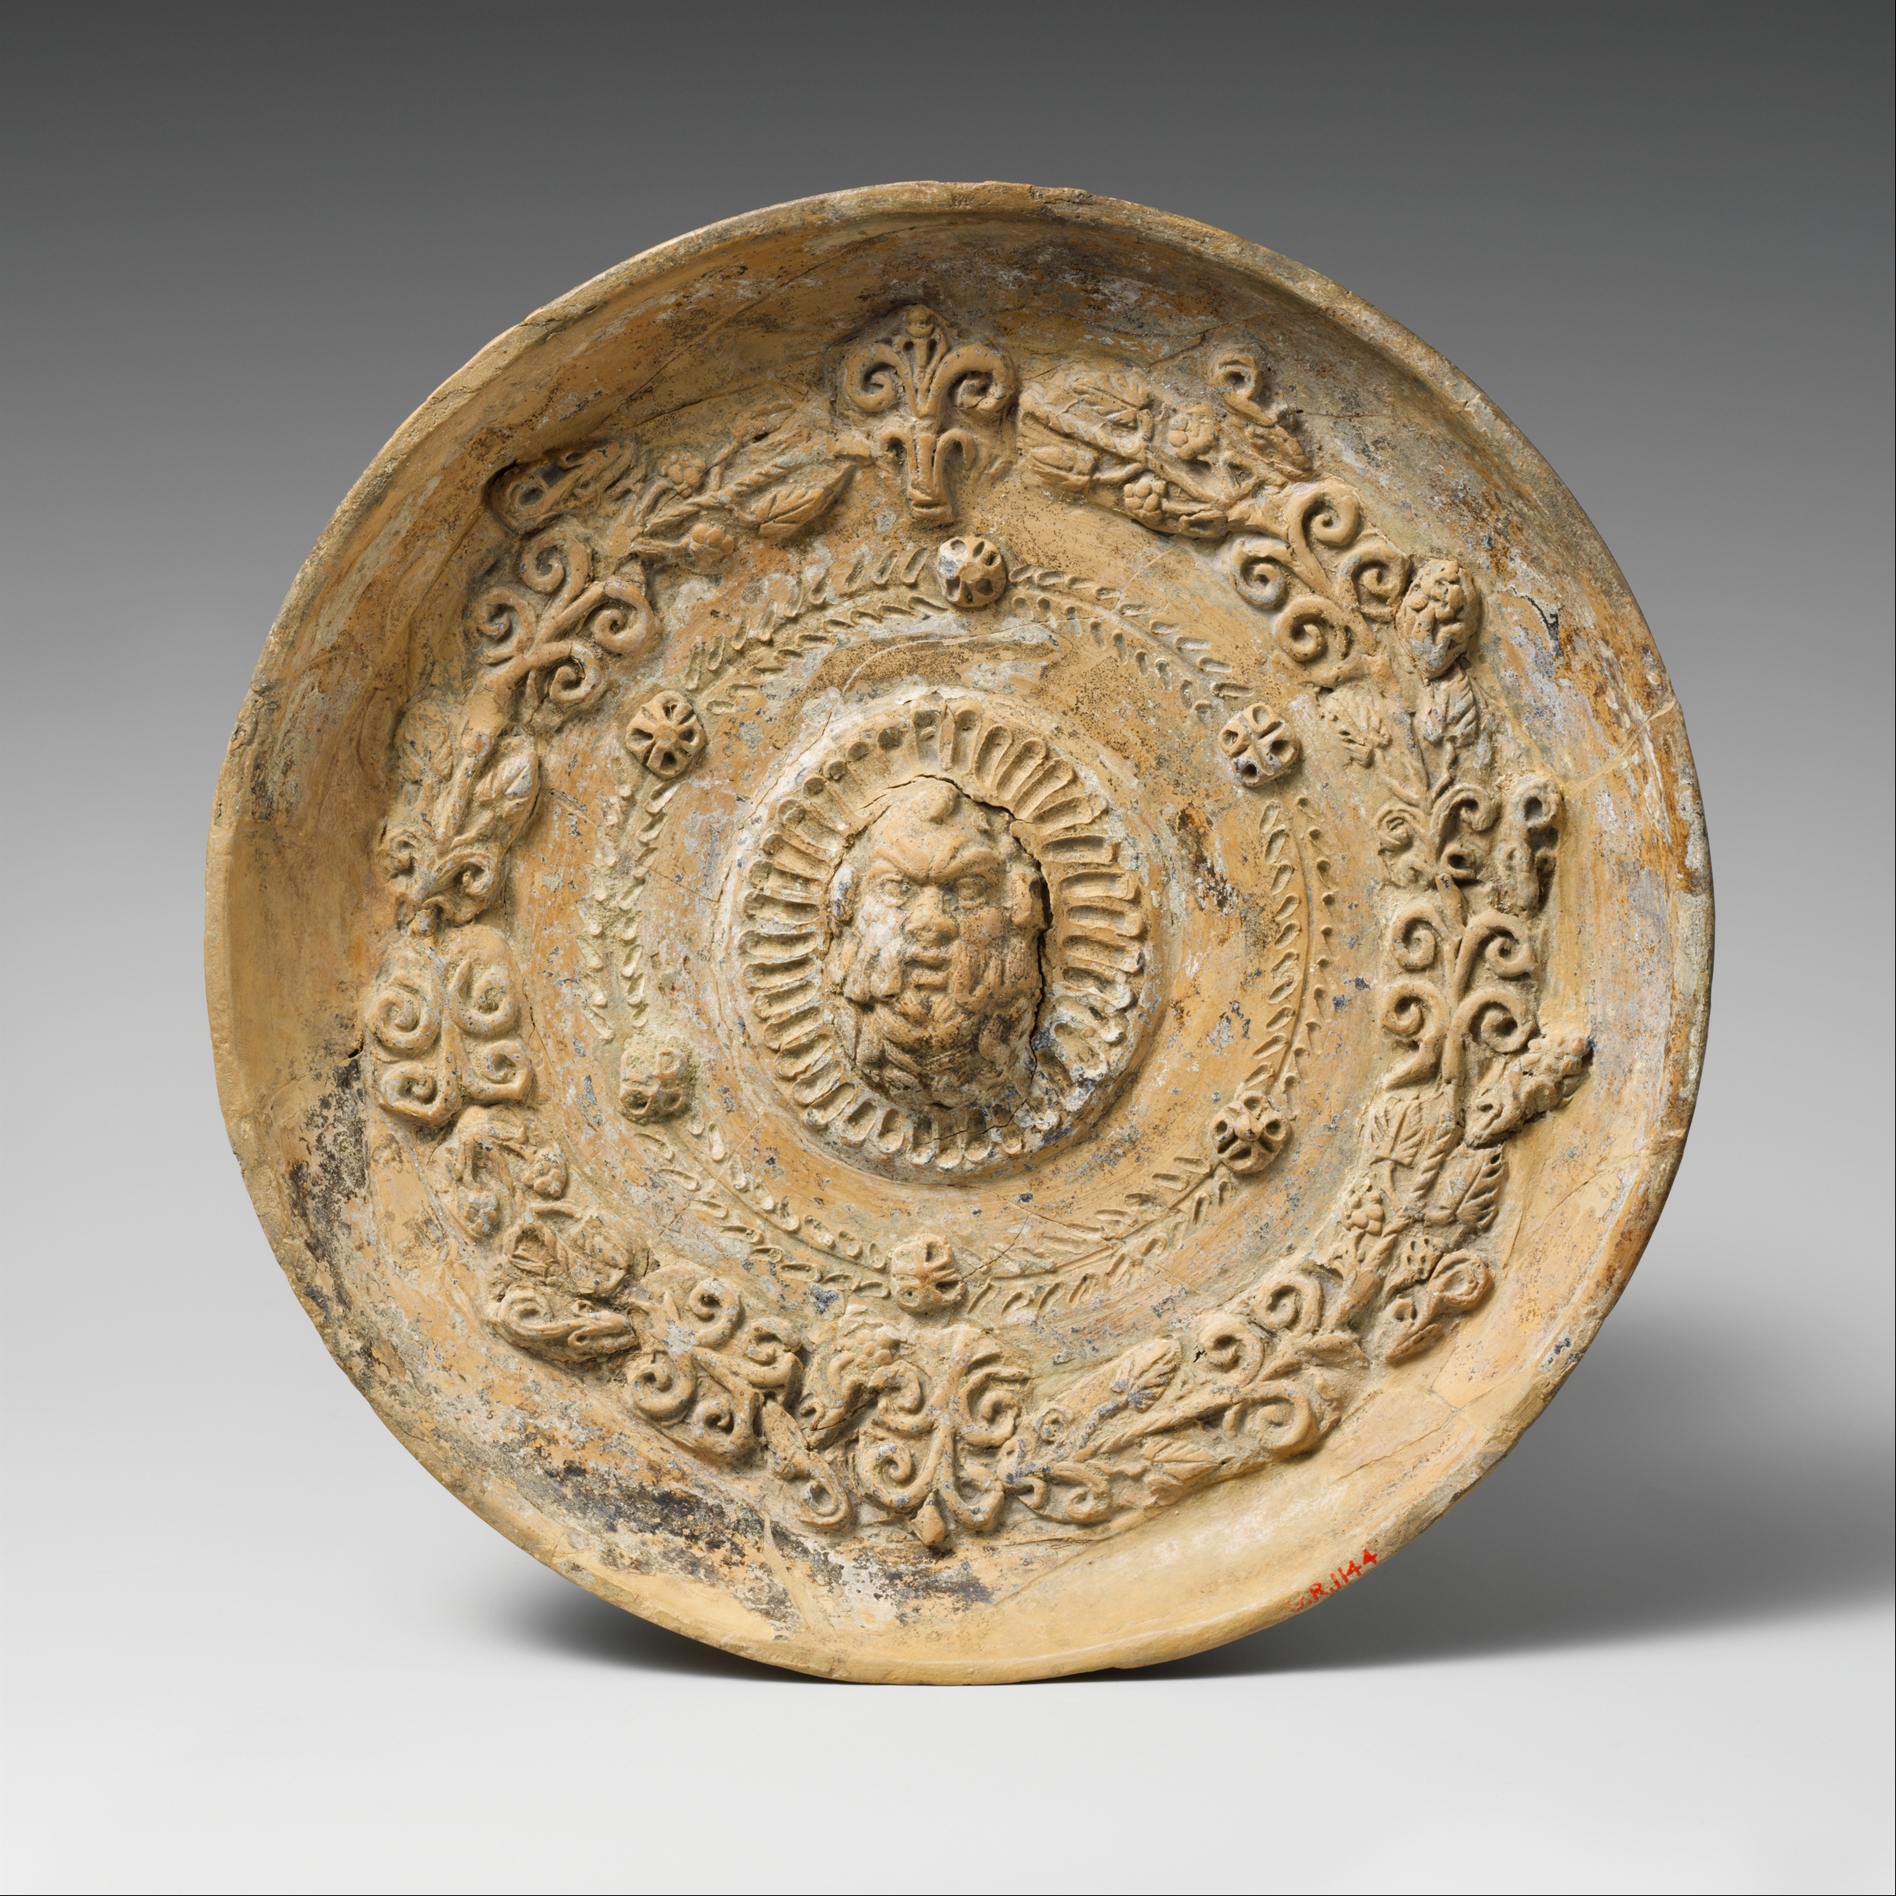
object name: phiale, silvered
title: Terracotta phiale (libation bowl)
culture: etruscan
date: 250-200 BCE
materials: terracotta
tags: satyrs